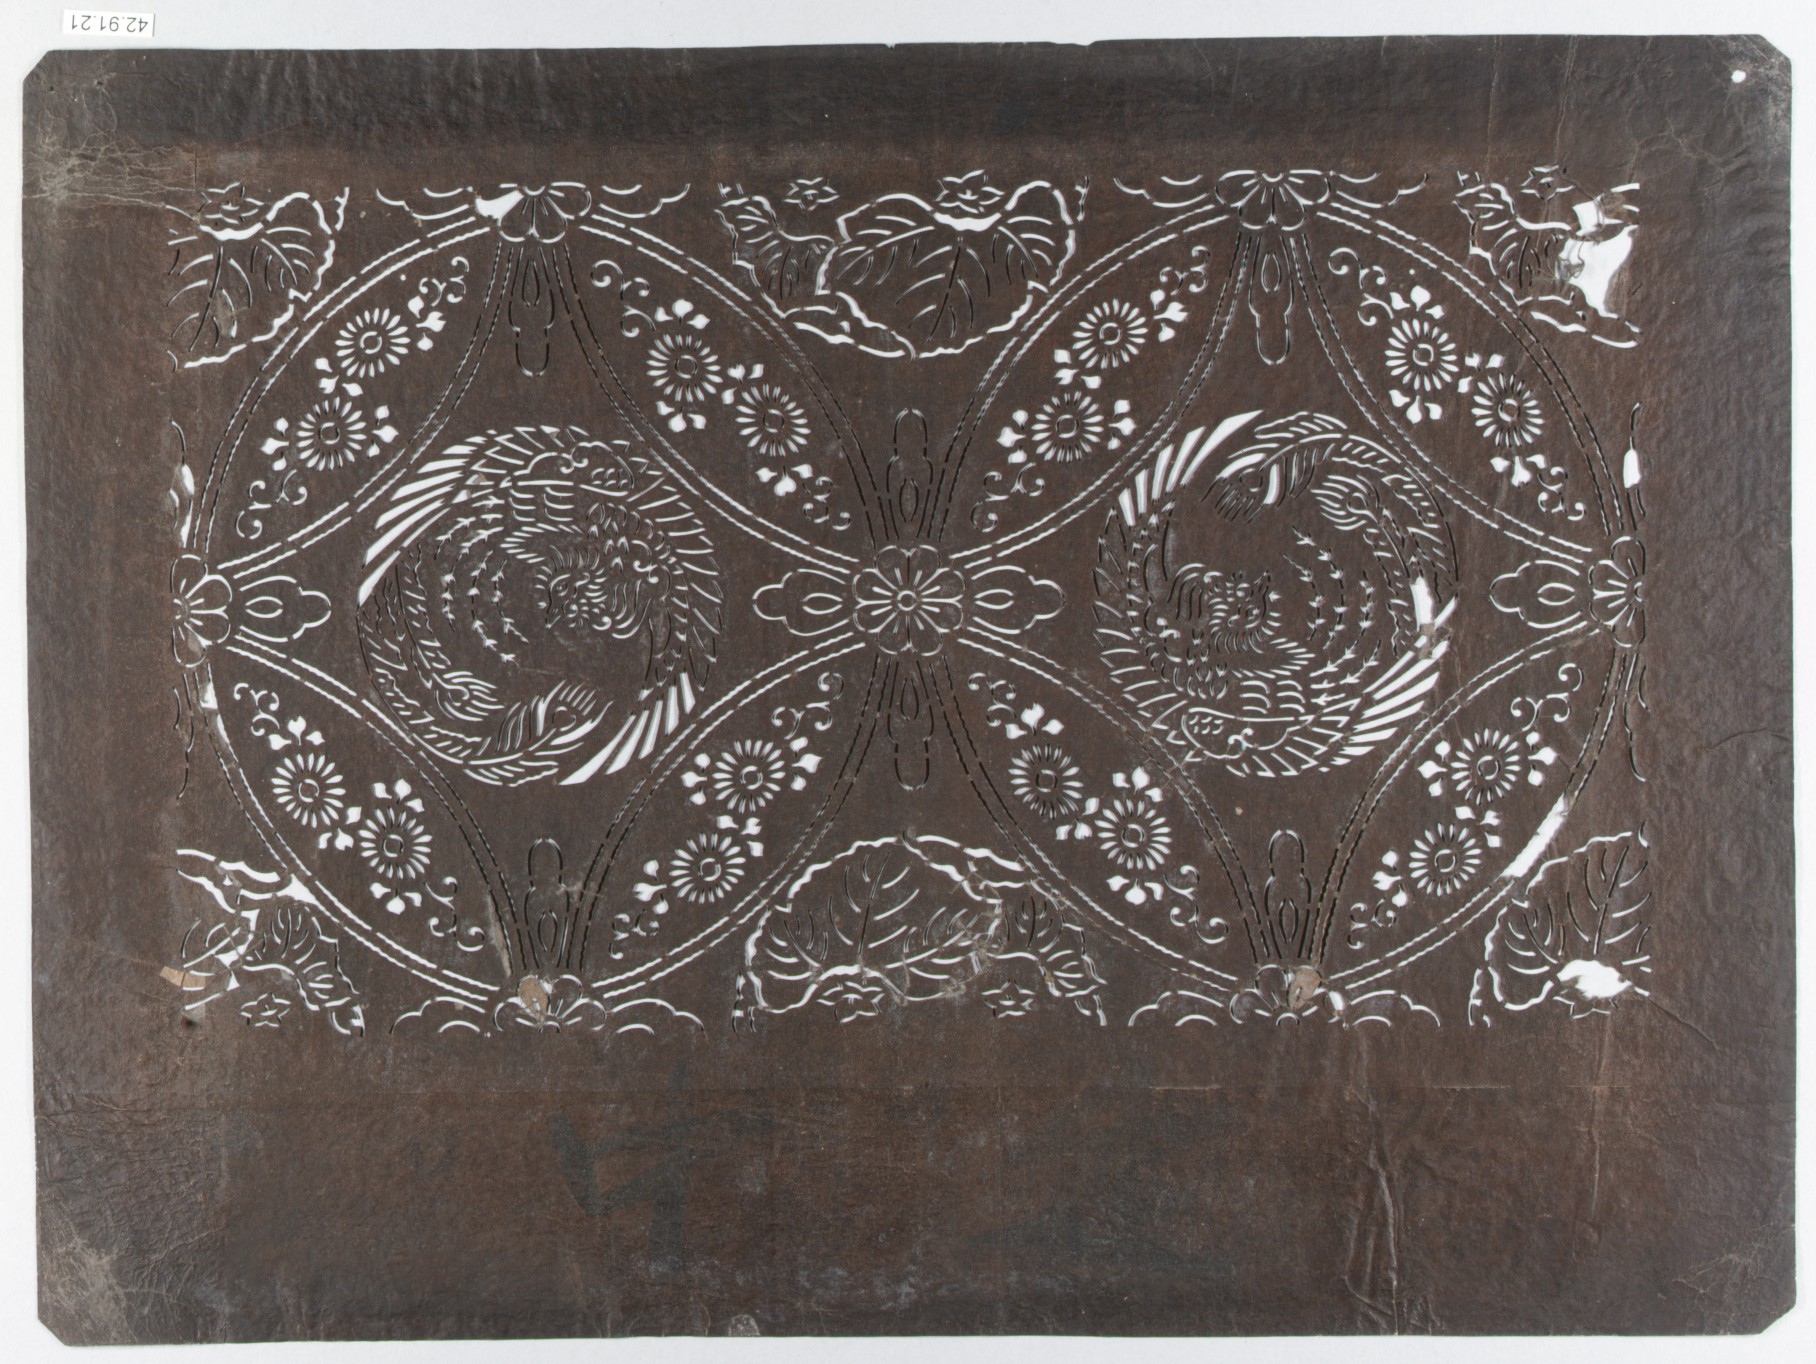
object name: stencil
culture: japanese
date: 1801-1900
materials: paper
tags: phoenix